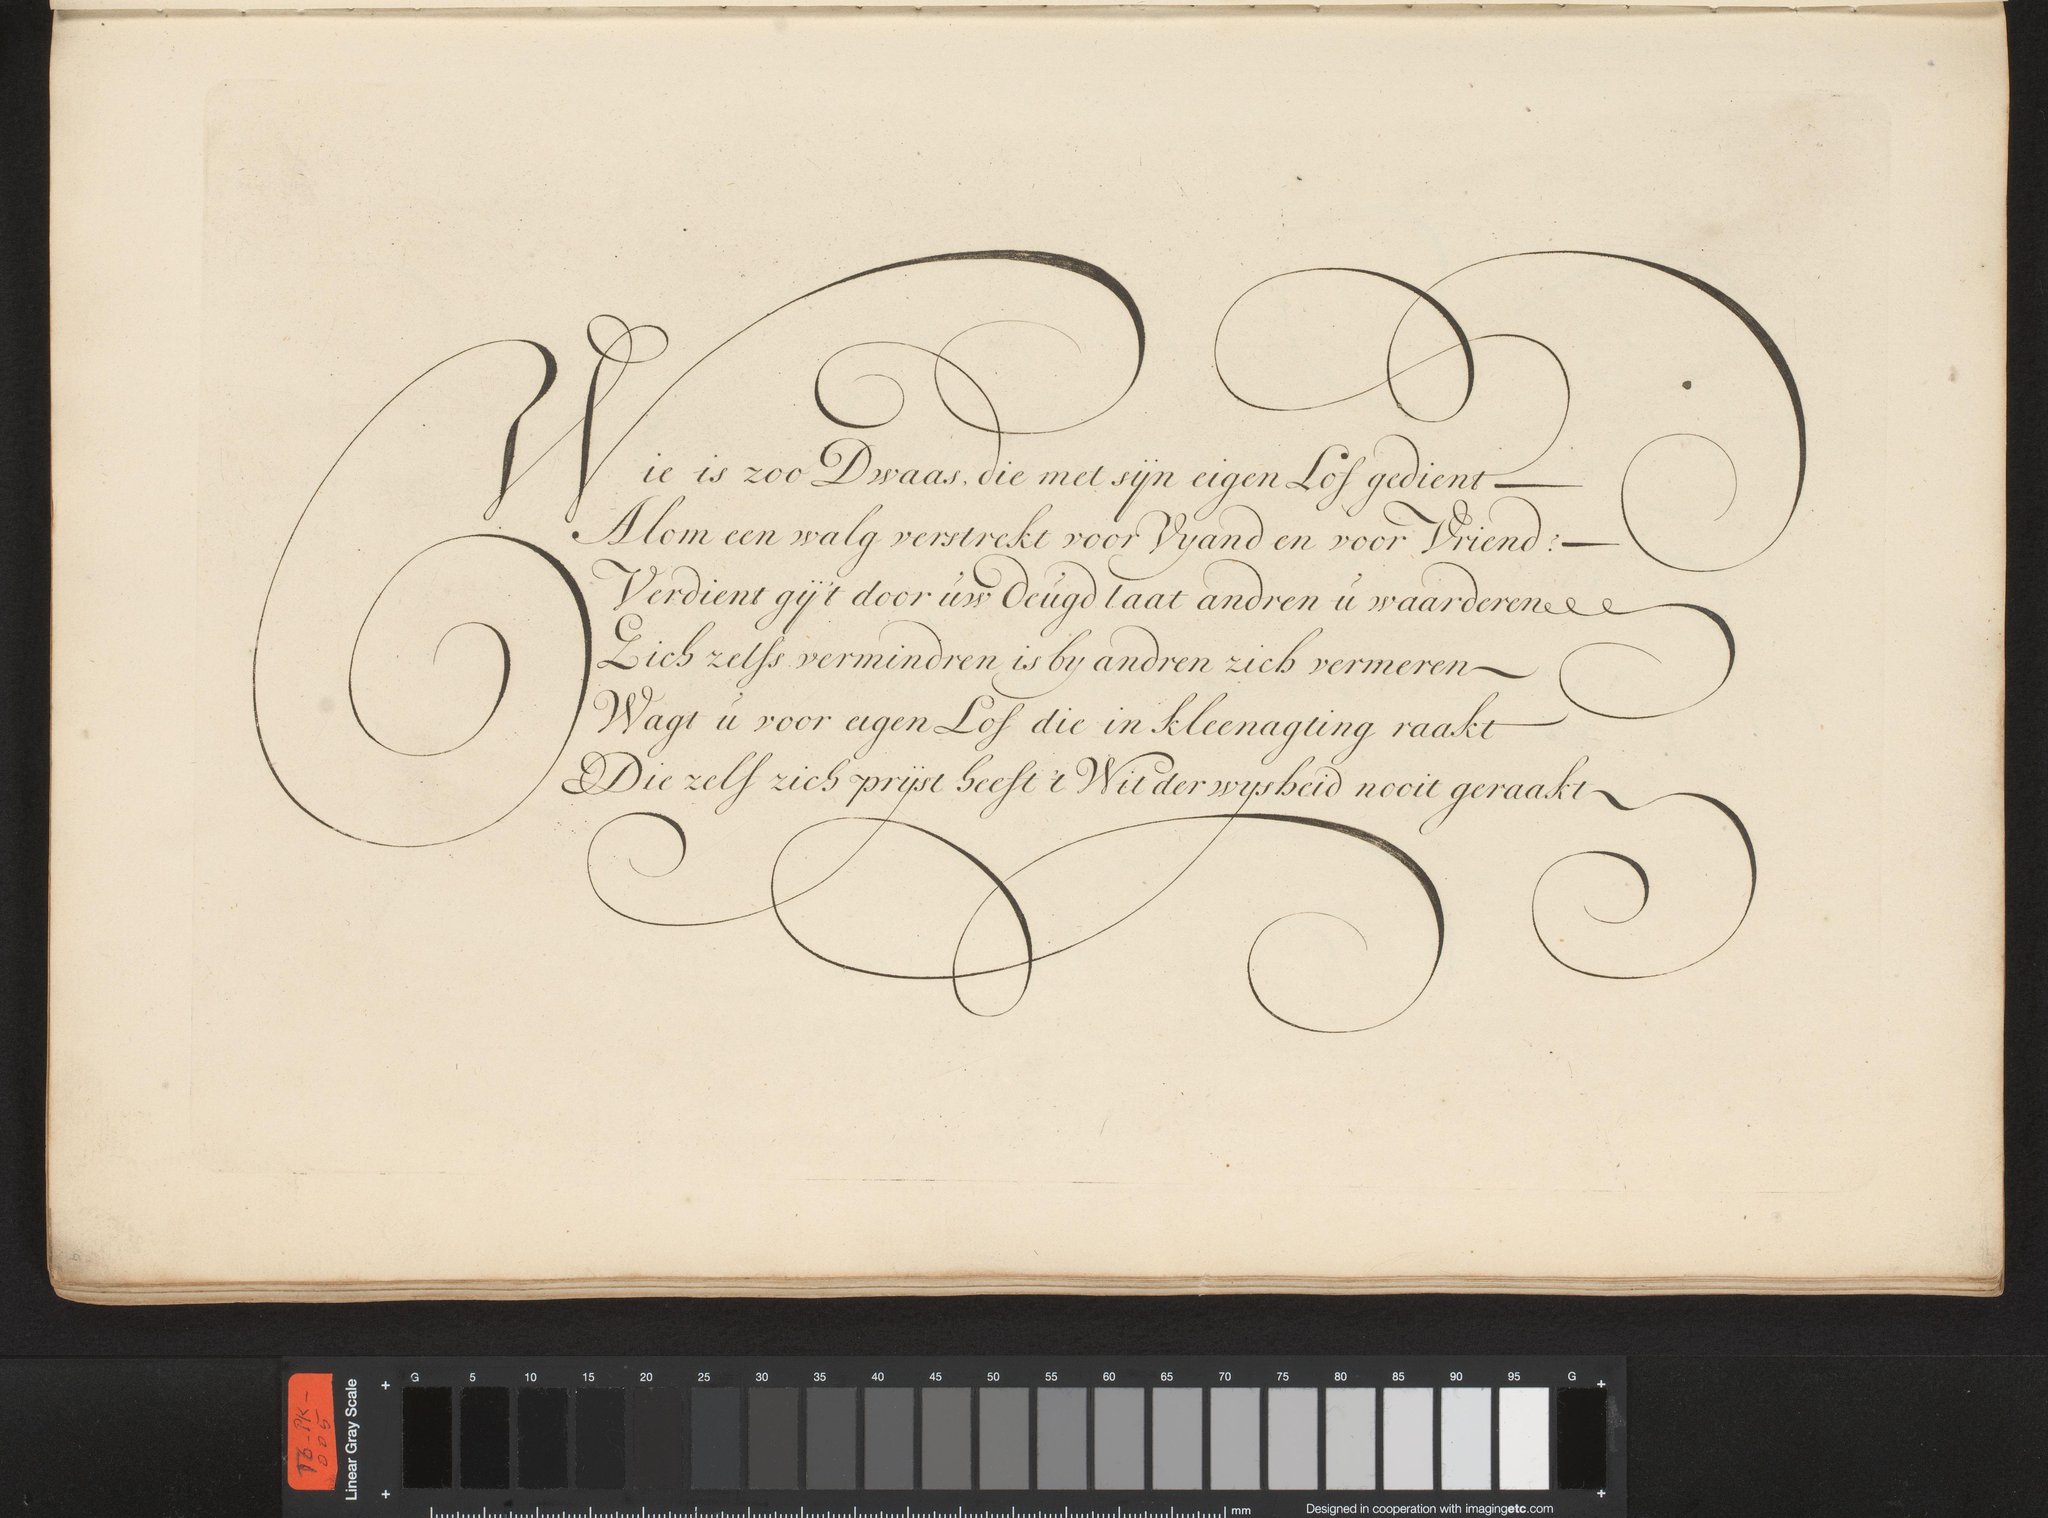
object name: album leaf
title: Schrijfvoorbeeld: Wie is zoo Dwaas (...)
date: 1660-1751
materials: paper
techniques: engraving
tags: calligraphy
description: Schrijfvoorbeeld met zes regels tekst in het Nederlands: Wie is zoo Dwaas ... De prent maakt deel uit van een album